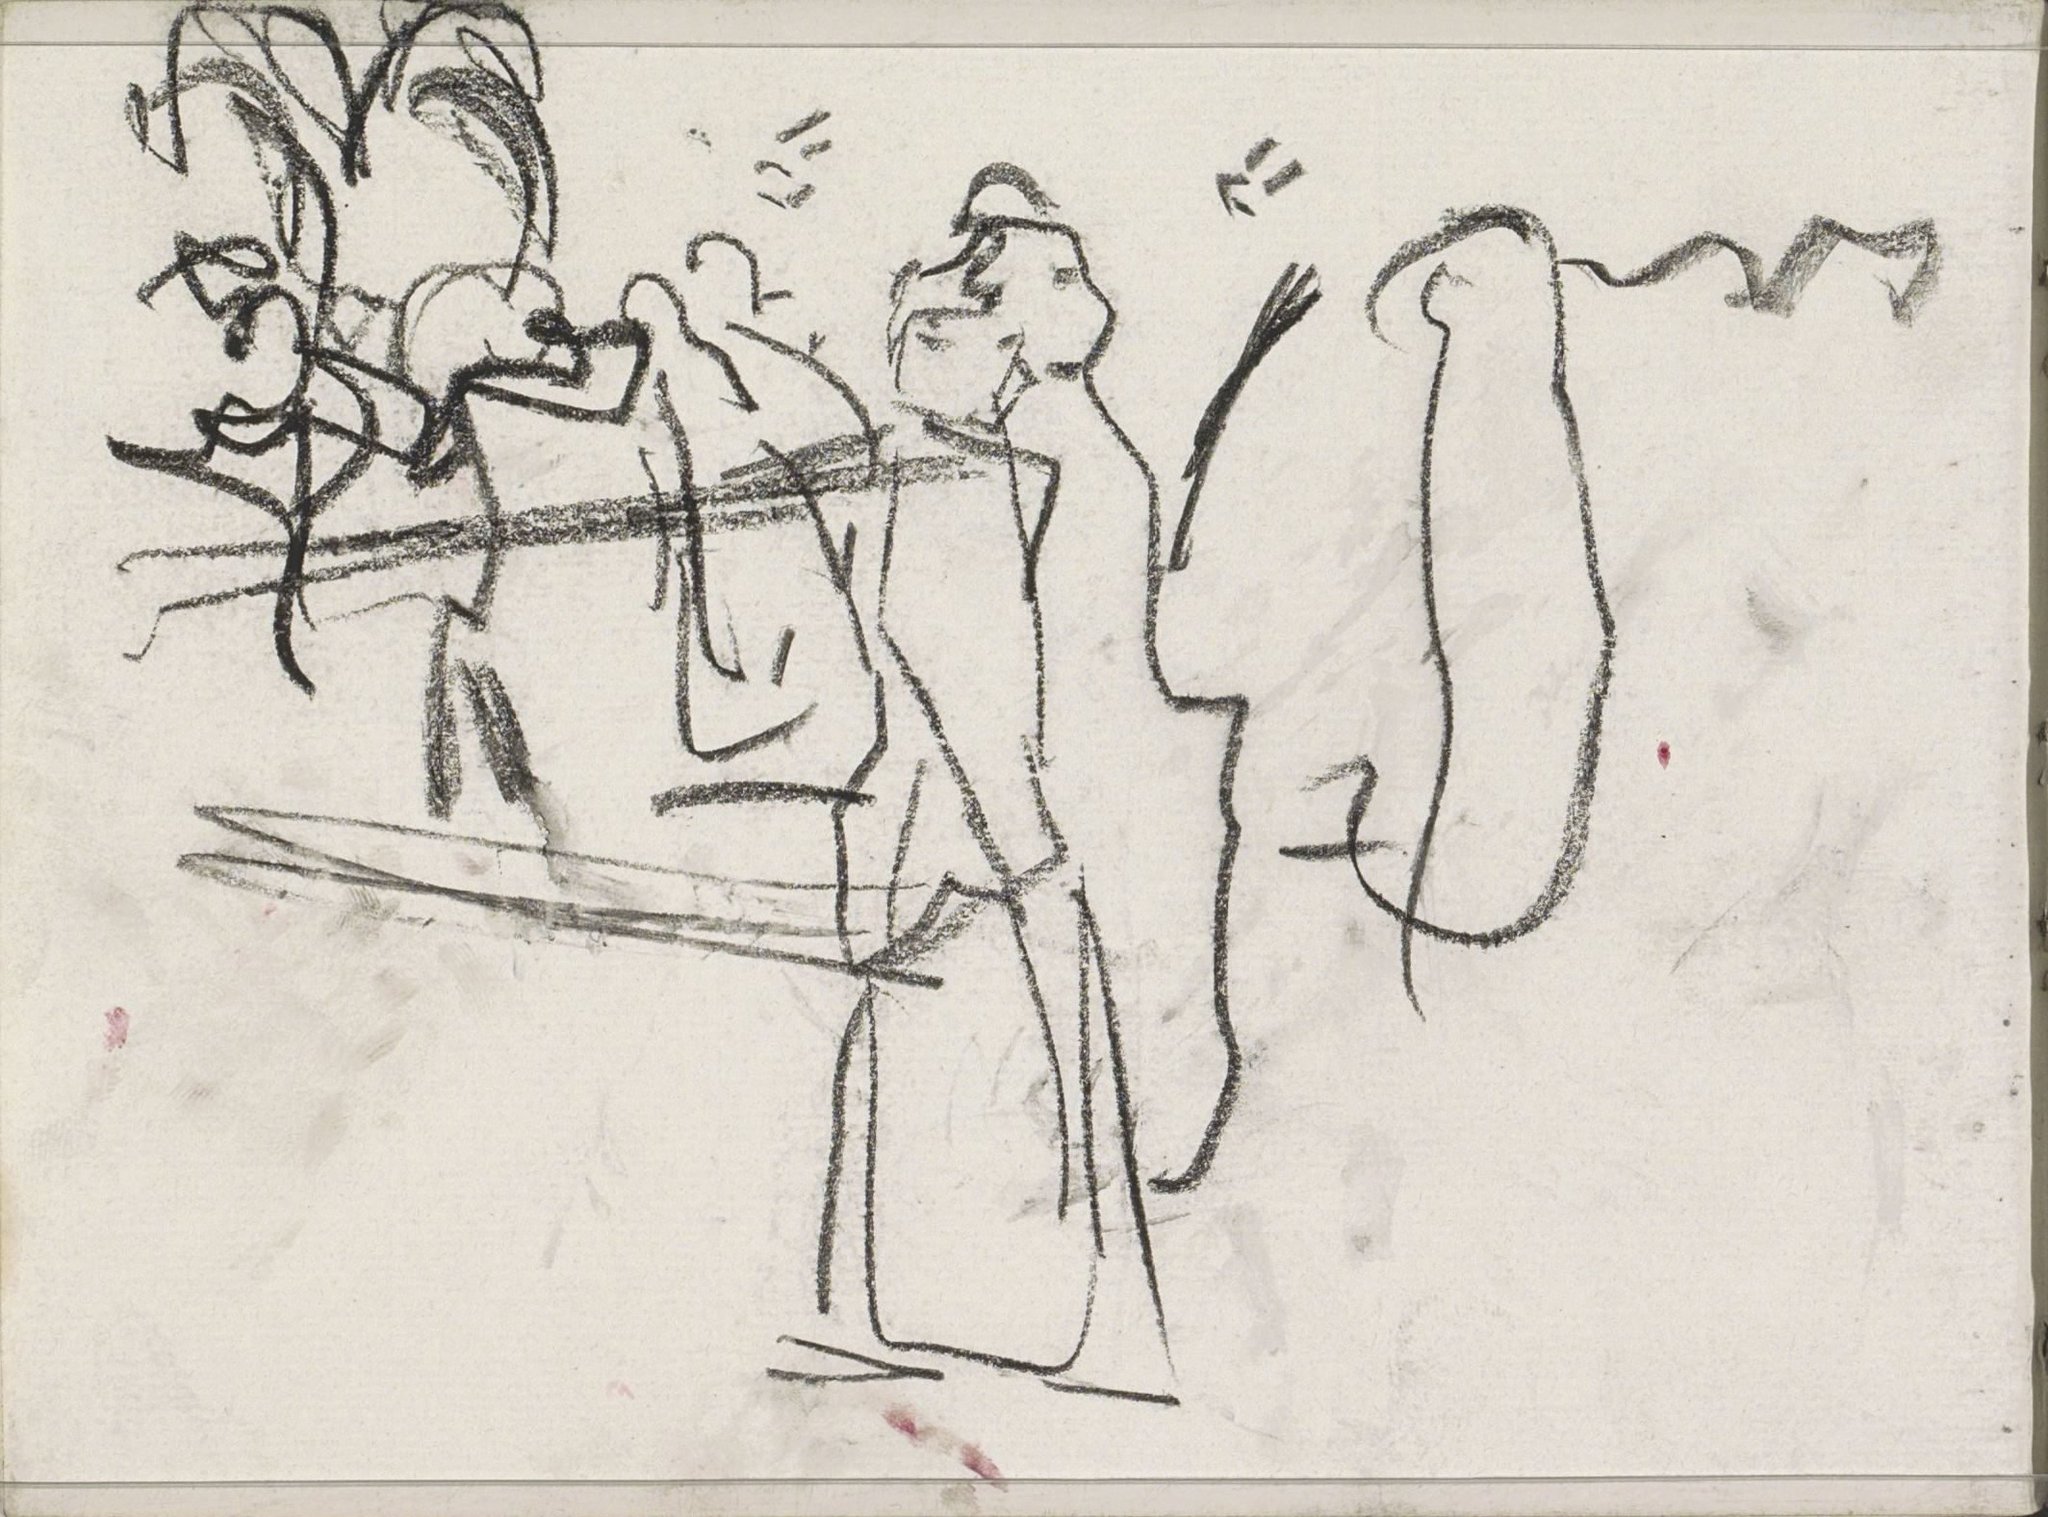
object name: sketchbook leaf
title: Figuren, mogelijk wandelend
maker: isaac israels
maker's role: draughtsman, painter, print maker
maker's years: 1865-1934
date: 1875-1934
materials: chalk, paper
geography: the hague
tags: adult woman, walking, hiking (recreation), adult man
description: Pagina 28 uit schetsboek XLI met 38 pagina's.